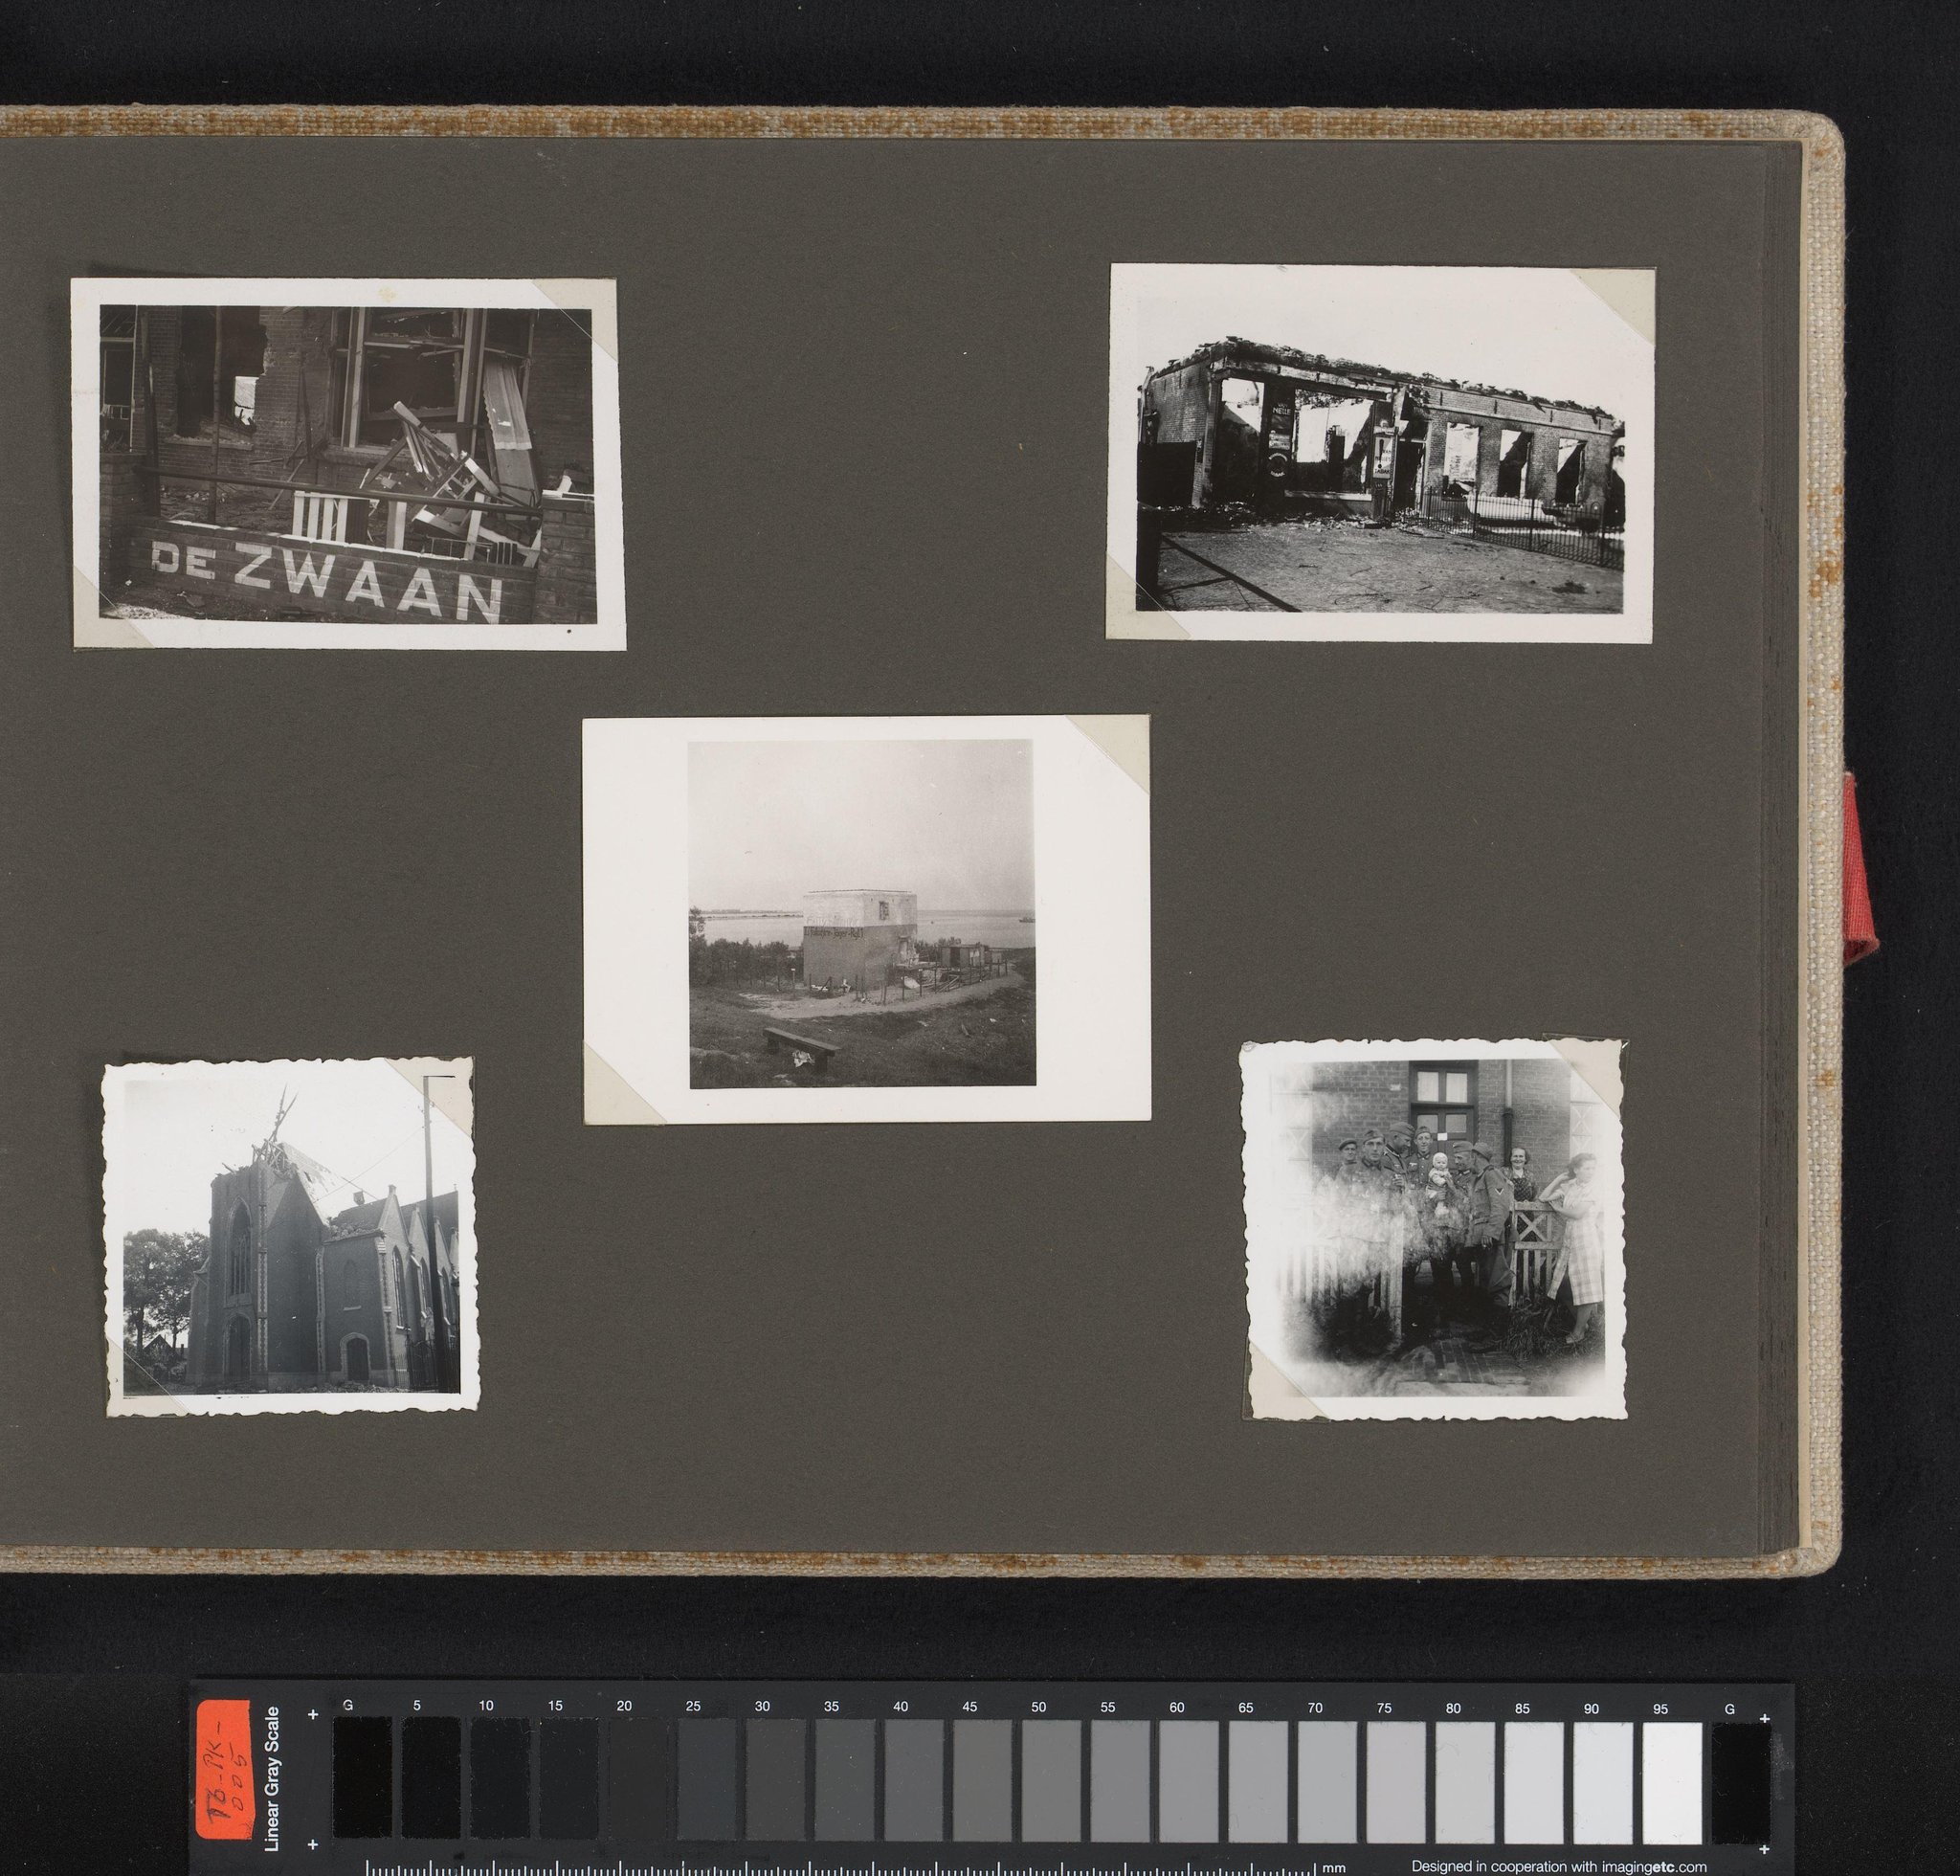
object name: album leaf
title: Oorlogsschade, mei 1940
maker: Anonymous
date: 1905-1940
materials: cardboard, photographic support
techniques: gelatin silver print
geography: netherlands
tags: (military) attack, devastated, ruined place or city (~ warfare), occupation ~ war, netherlands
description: Albumblad met vijf foto's van oorlogsschade aan gebouwen in Nederland na de inval van de Duitsers in mei 1940. Foto's van vermoedelijk een café genaamd De Zwaan, een kerk en een bunker met opschrift 'II/Fallschirm-Jäger-Rgt.1', bij de brug over de Waal bij Moerdijk. Onderdeel van de fotoalbum van de Wehrmacht 1938-1941.